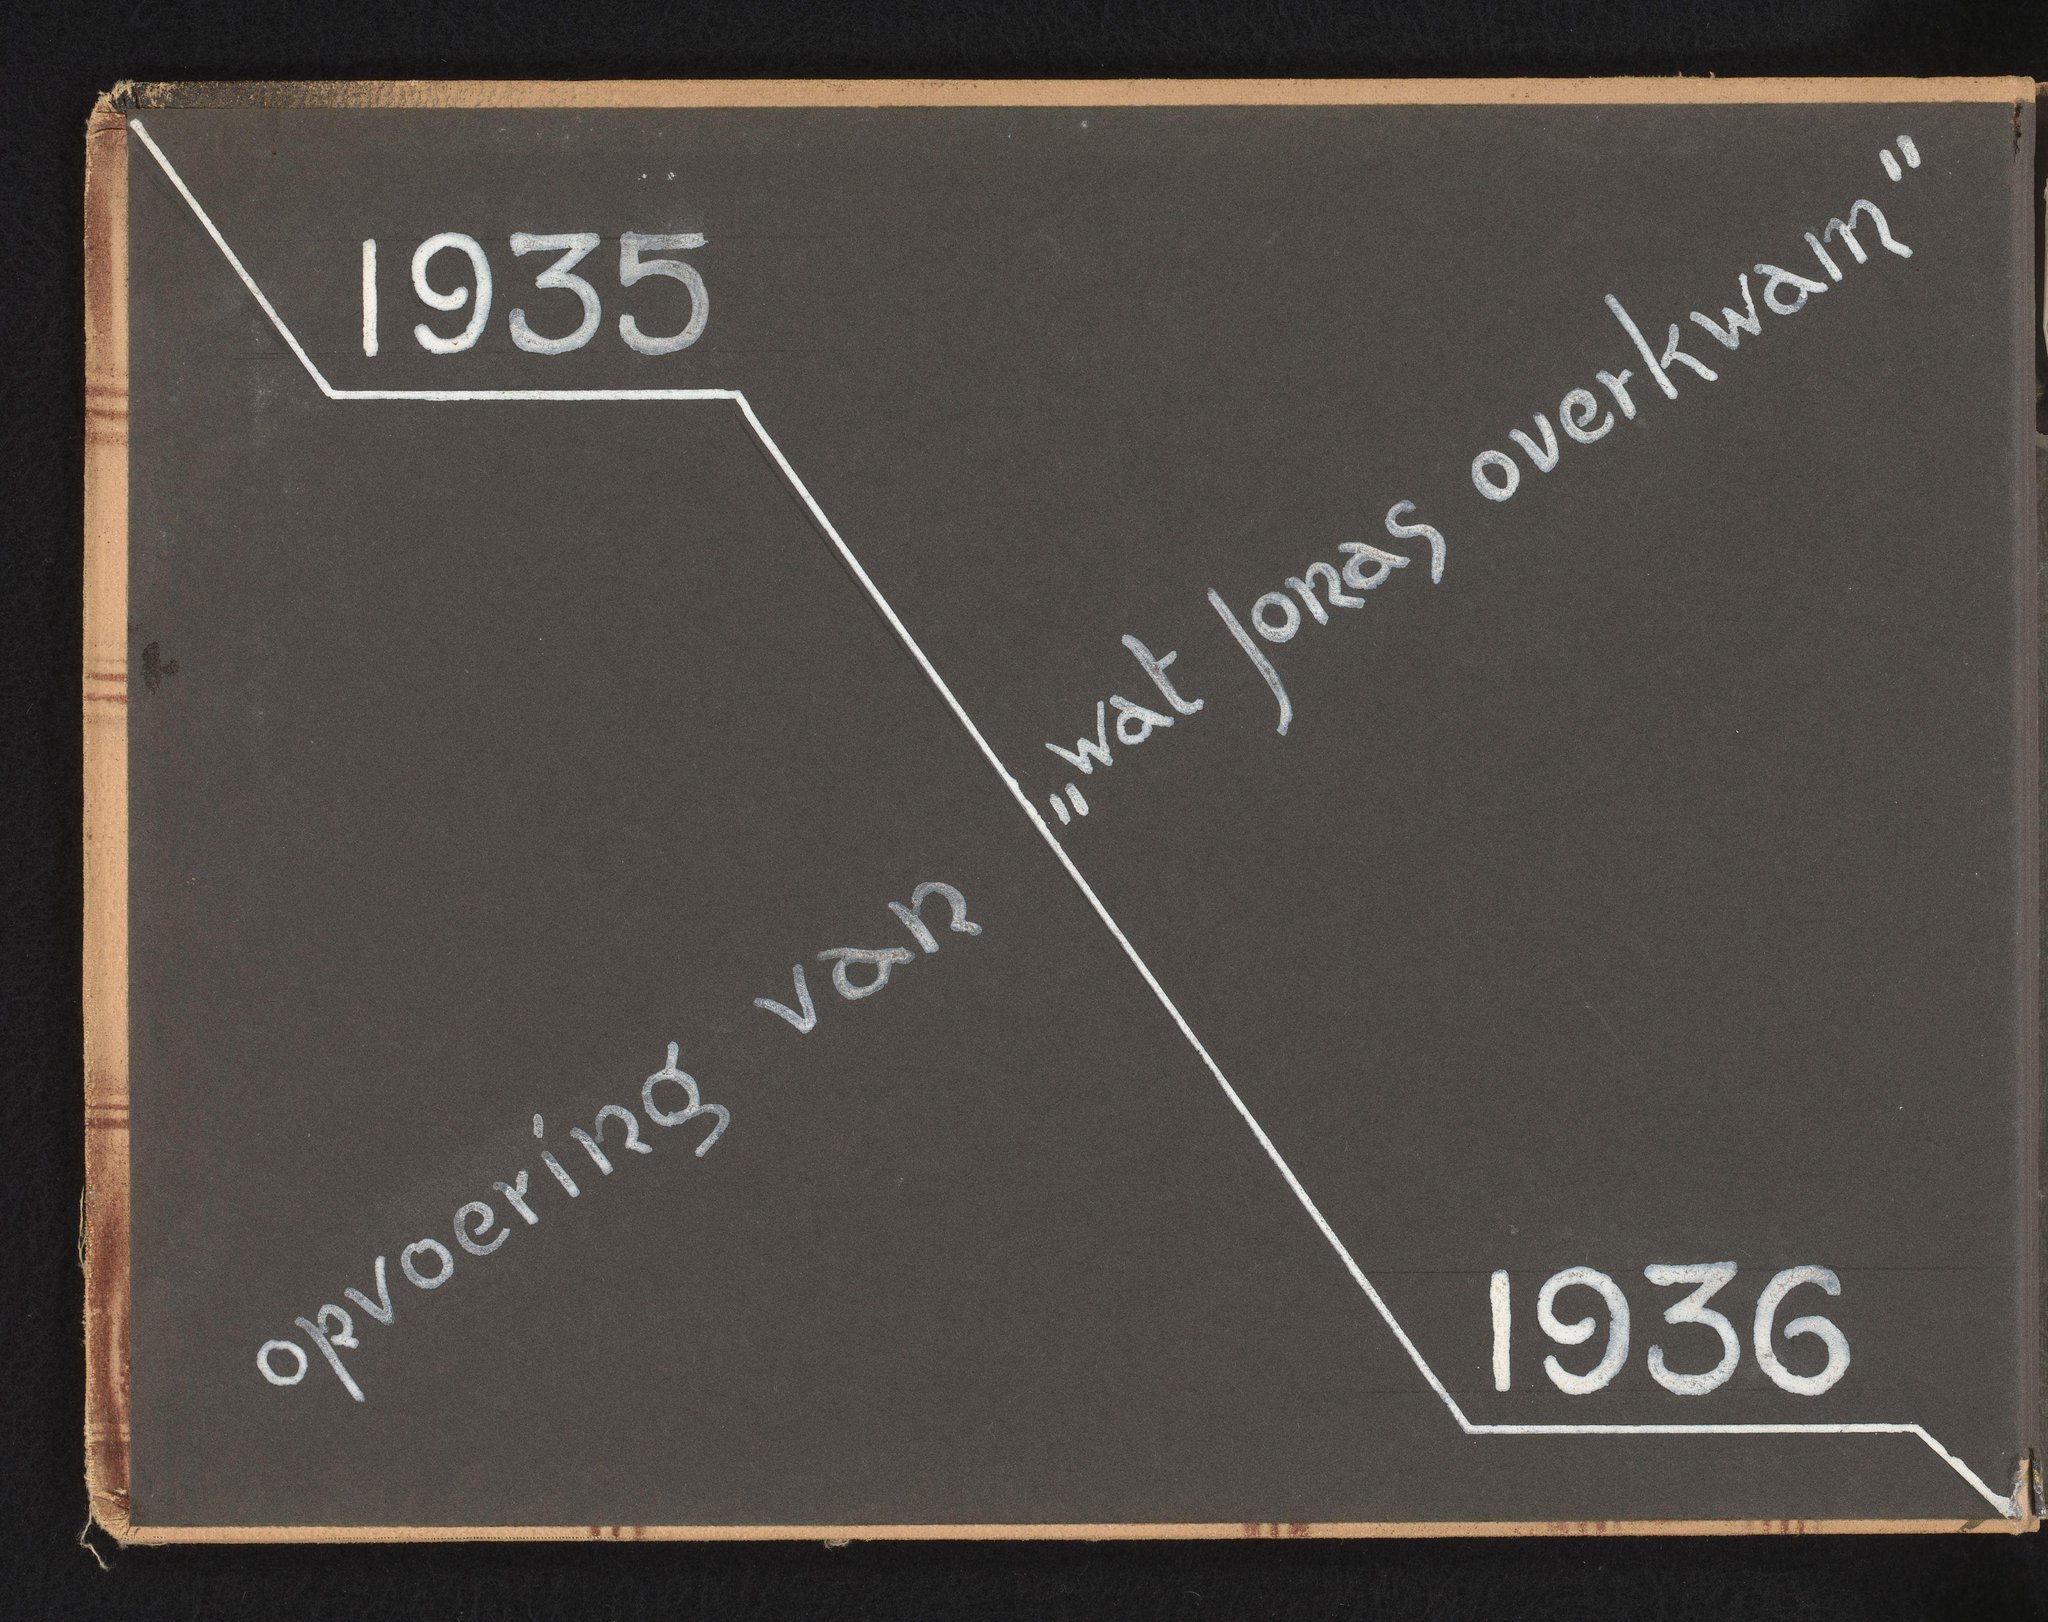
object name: manuscript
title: 1935 1936 / opvoering van 'Wat Jonas overkwam'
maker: Anonymous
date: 1936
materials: ink, paper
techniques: pen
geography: haarlem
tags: haarlem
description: Titel van het toneelstuk dat opgevoerd werd op de 16de jaarlijkse feestavond van de leerlingen MTS op 22 februari 1936 in de stadsschouwburg te Haarlem. Blad met opschrift aan de binnenkant van het kaft uit het album Jaarfeesten van het Corps M.T.S. te Haarlem.